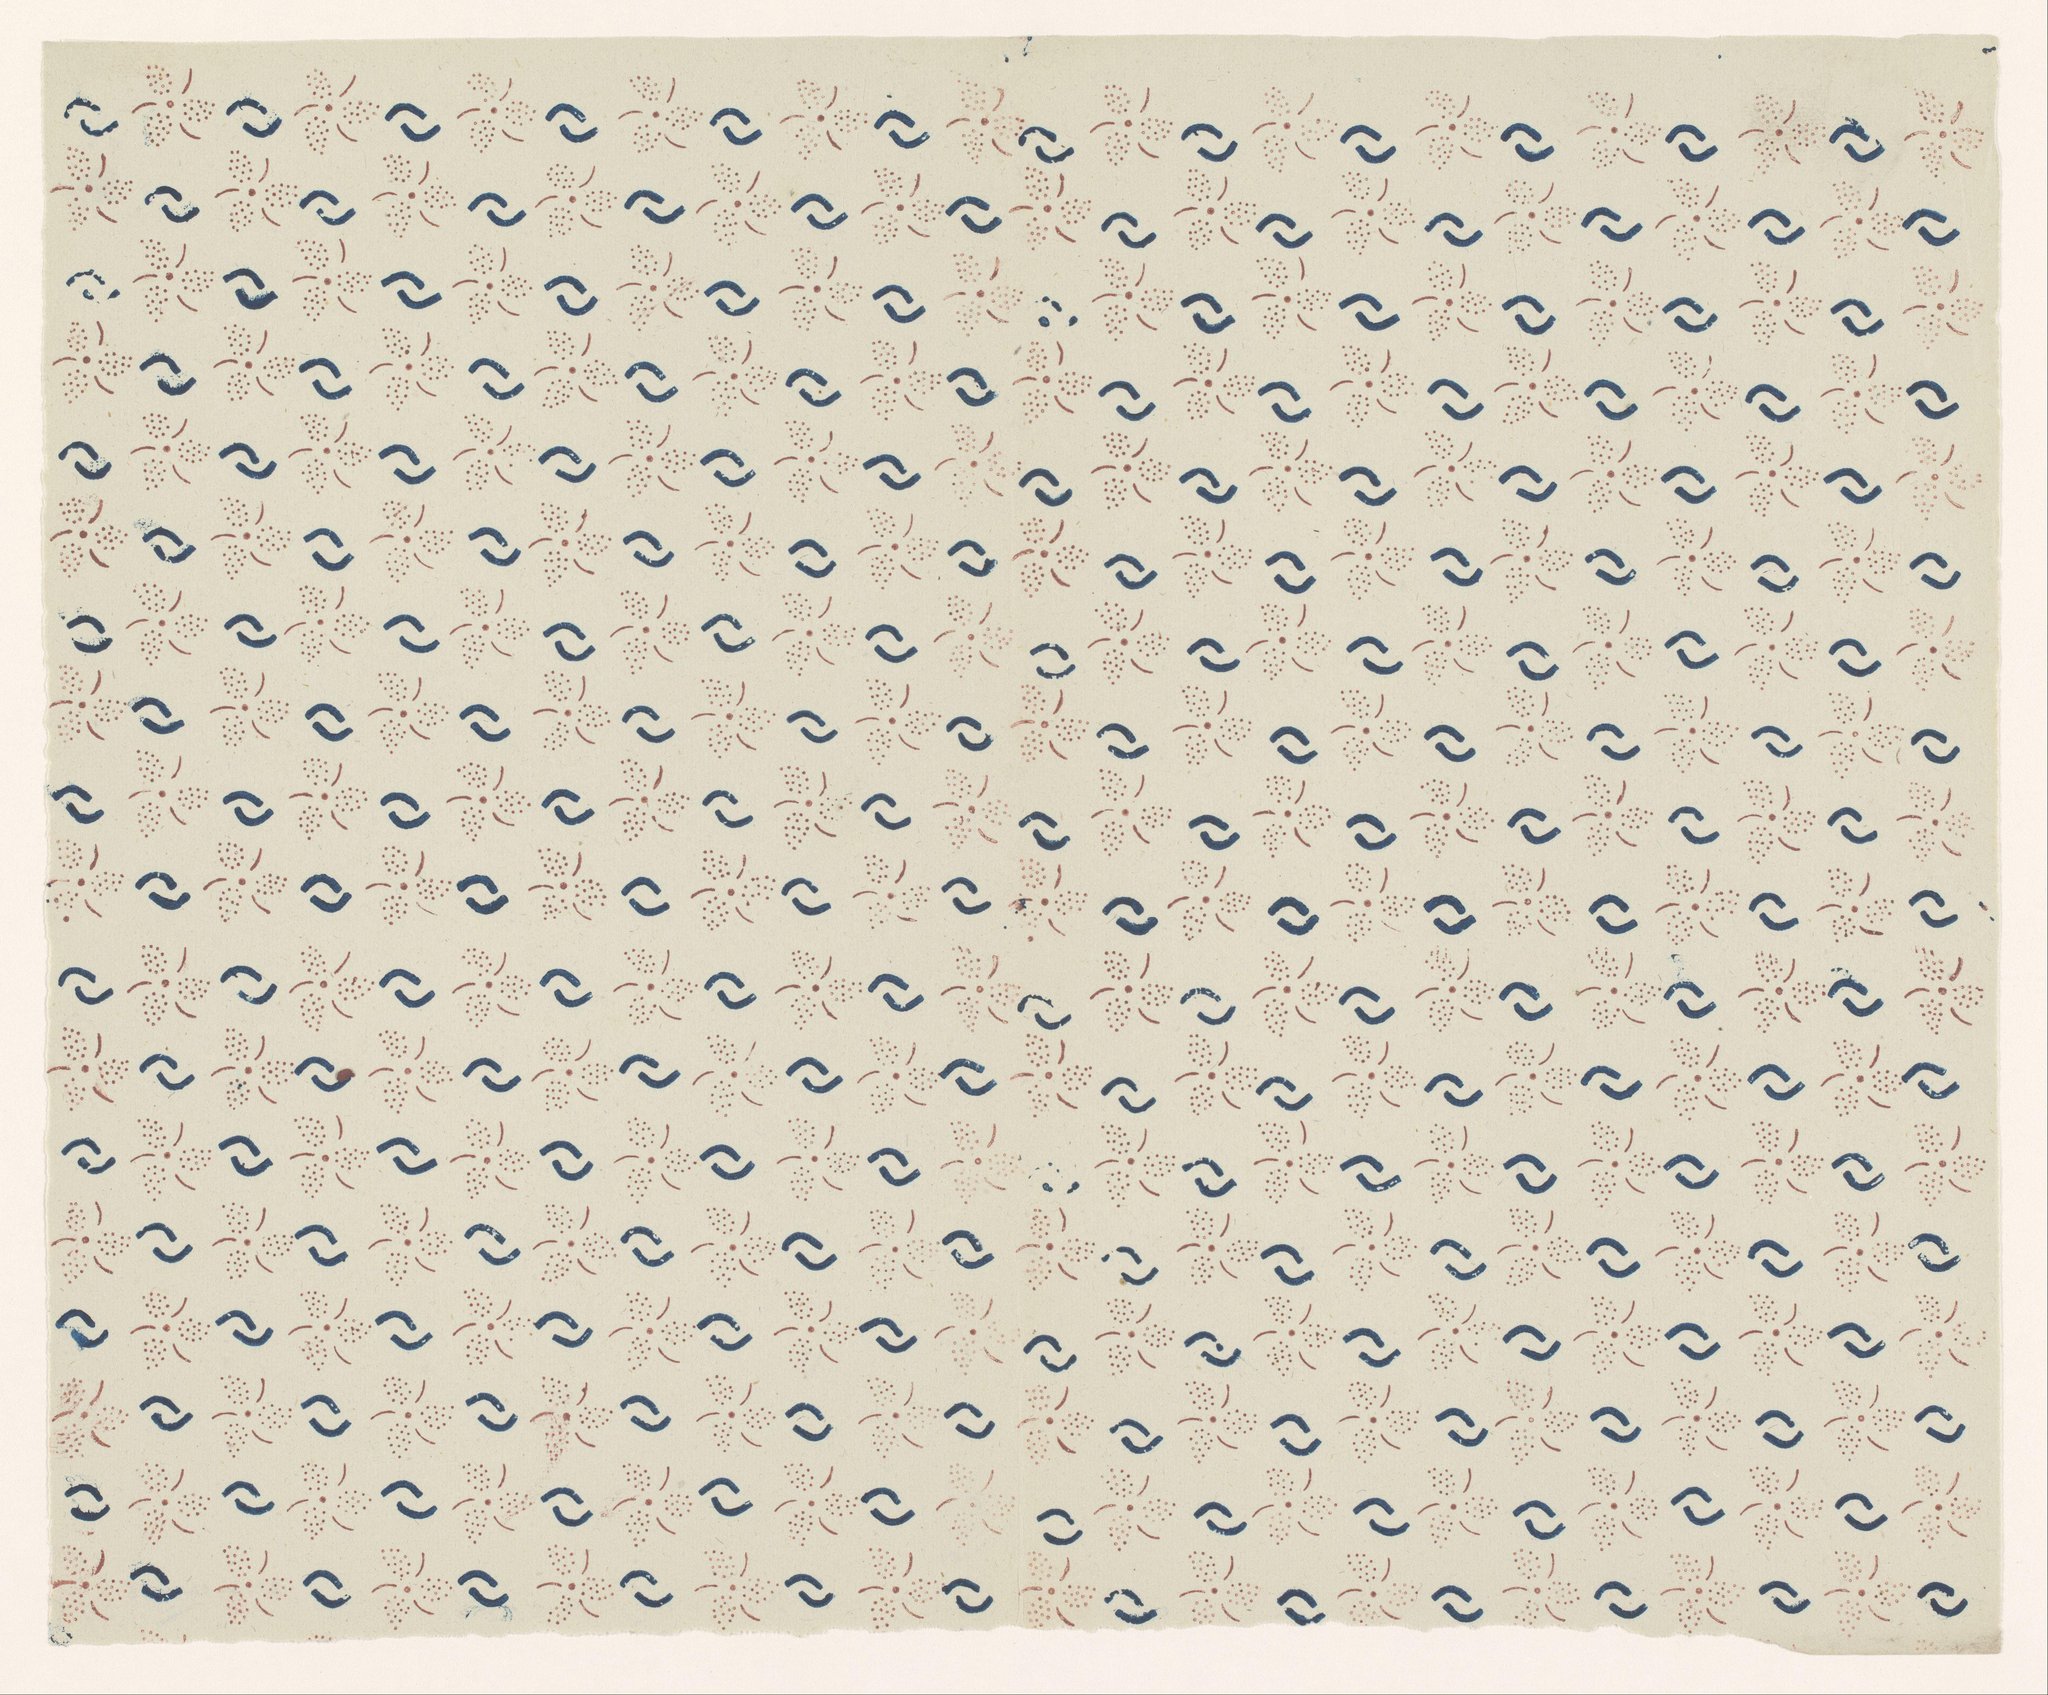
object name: printed paper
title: Blad met alternerend strooipatroon van boogjes en bladeren van punten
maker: Anonymous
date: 1800-1900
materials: paper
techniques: printing block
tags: ornament derived from plant forms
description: Blad met alternerend strooipatroon van boogjes en bladeren van punten en streepjes.